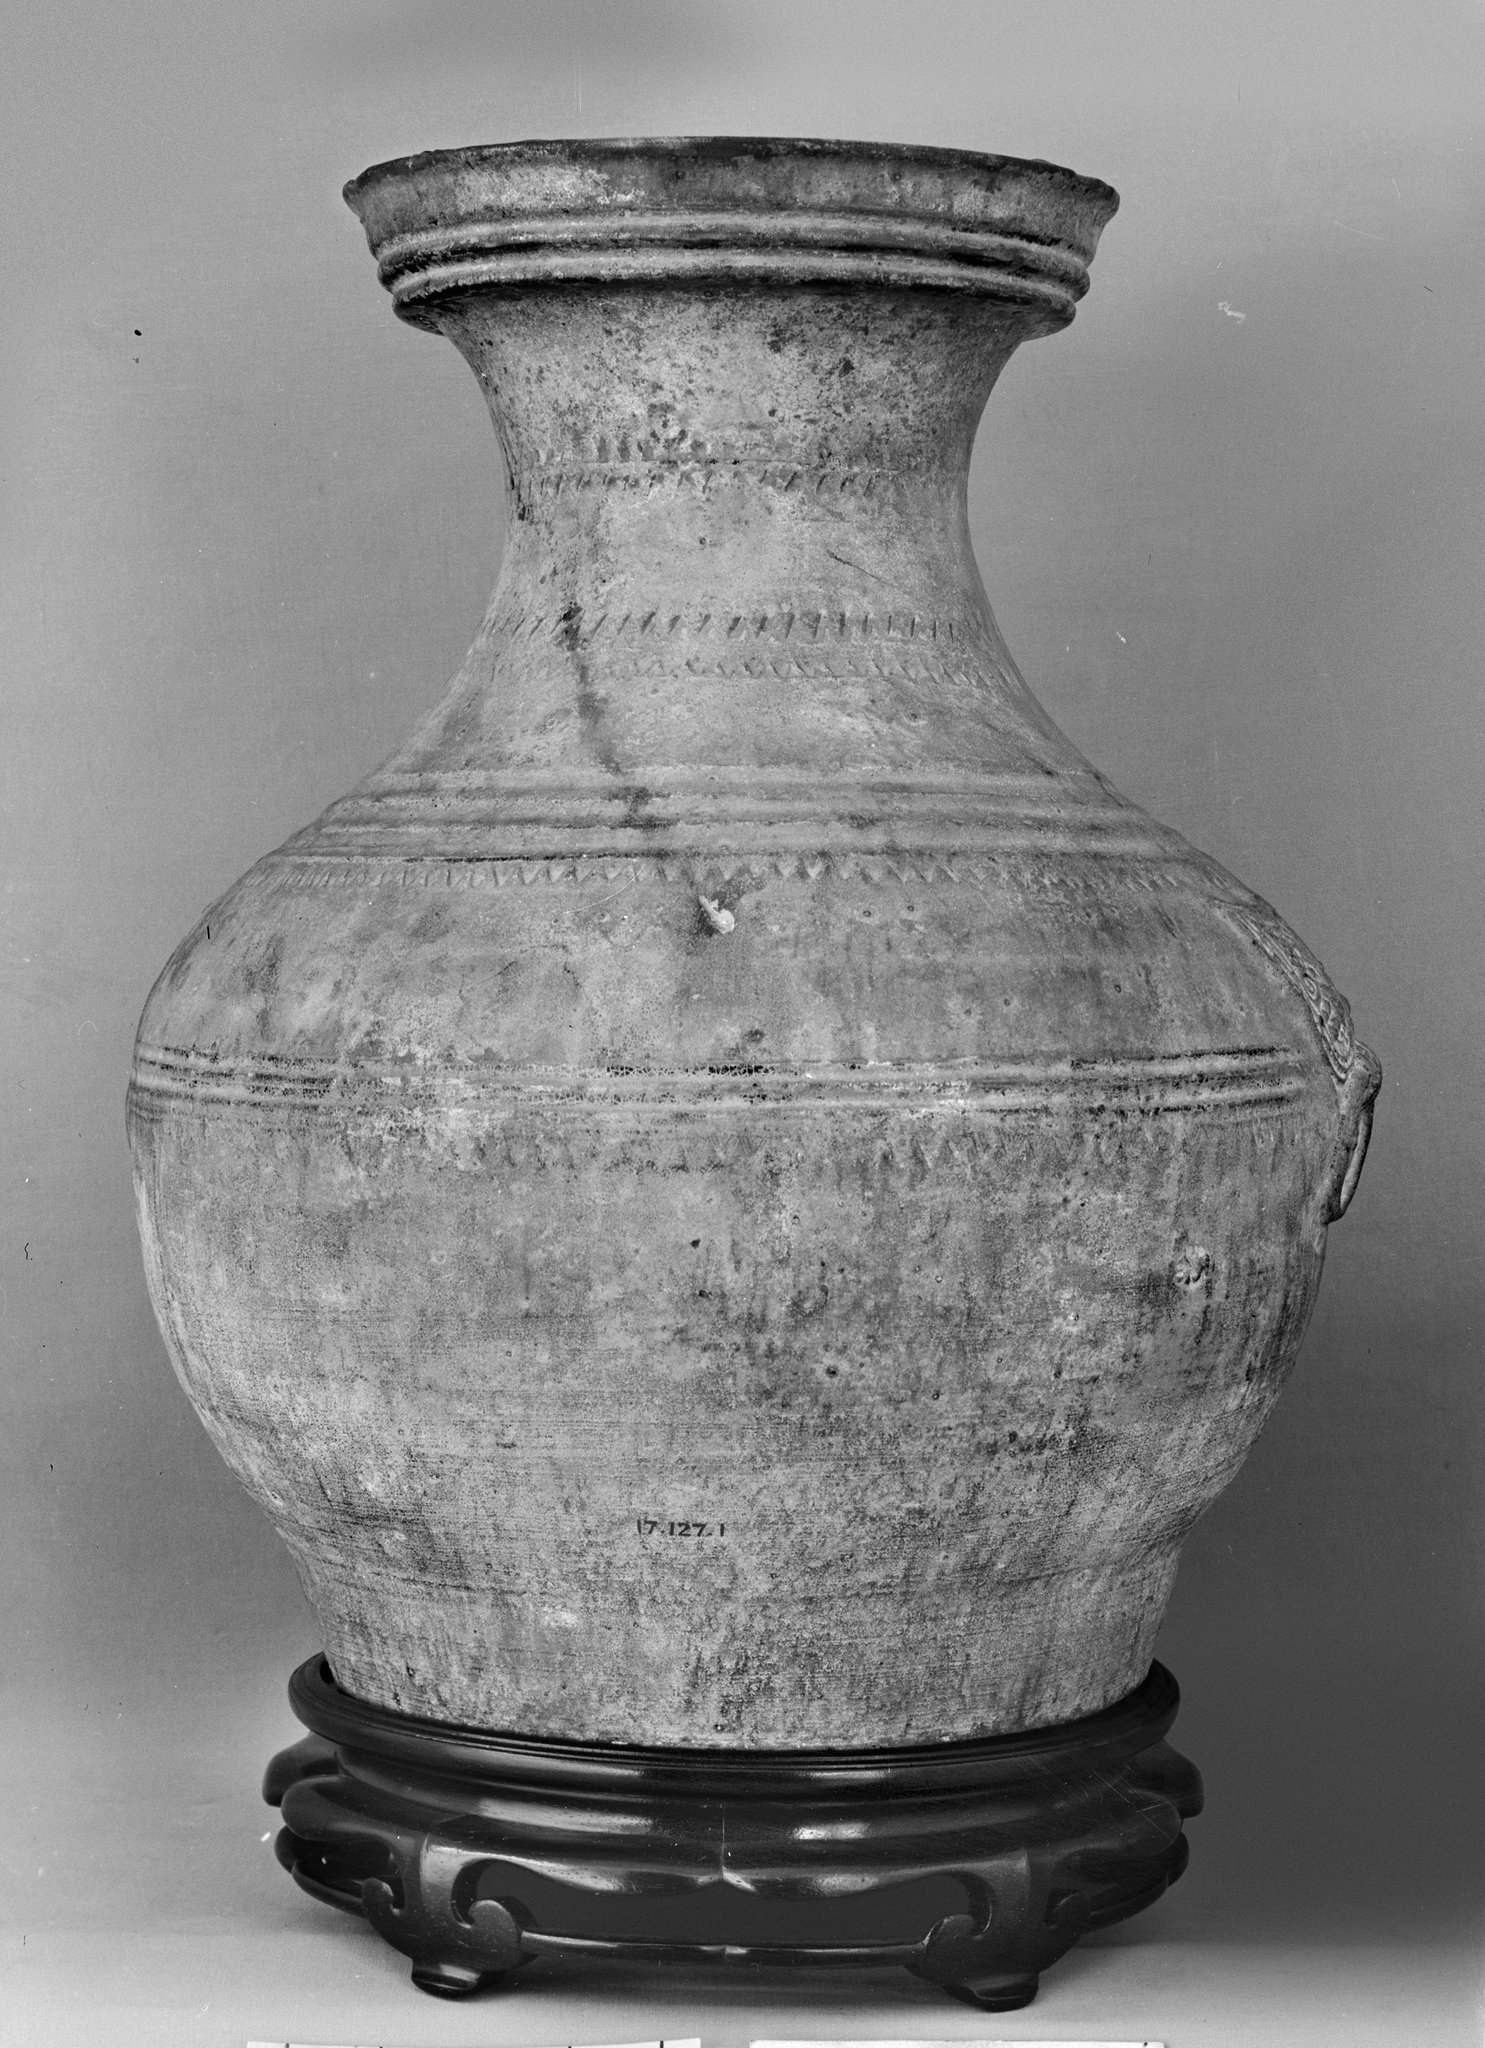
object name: jar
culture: chinese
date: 206 BCE-220 CE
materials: pottery